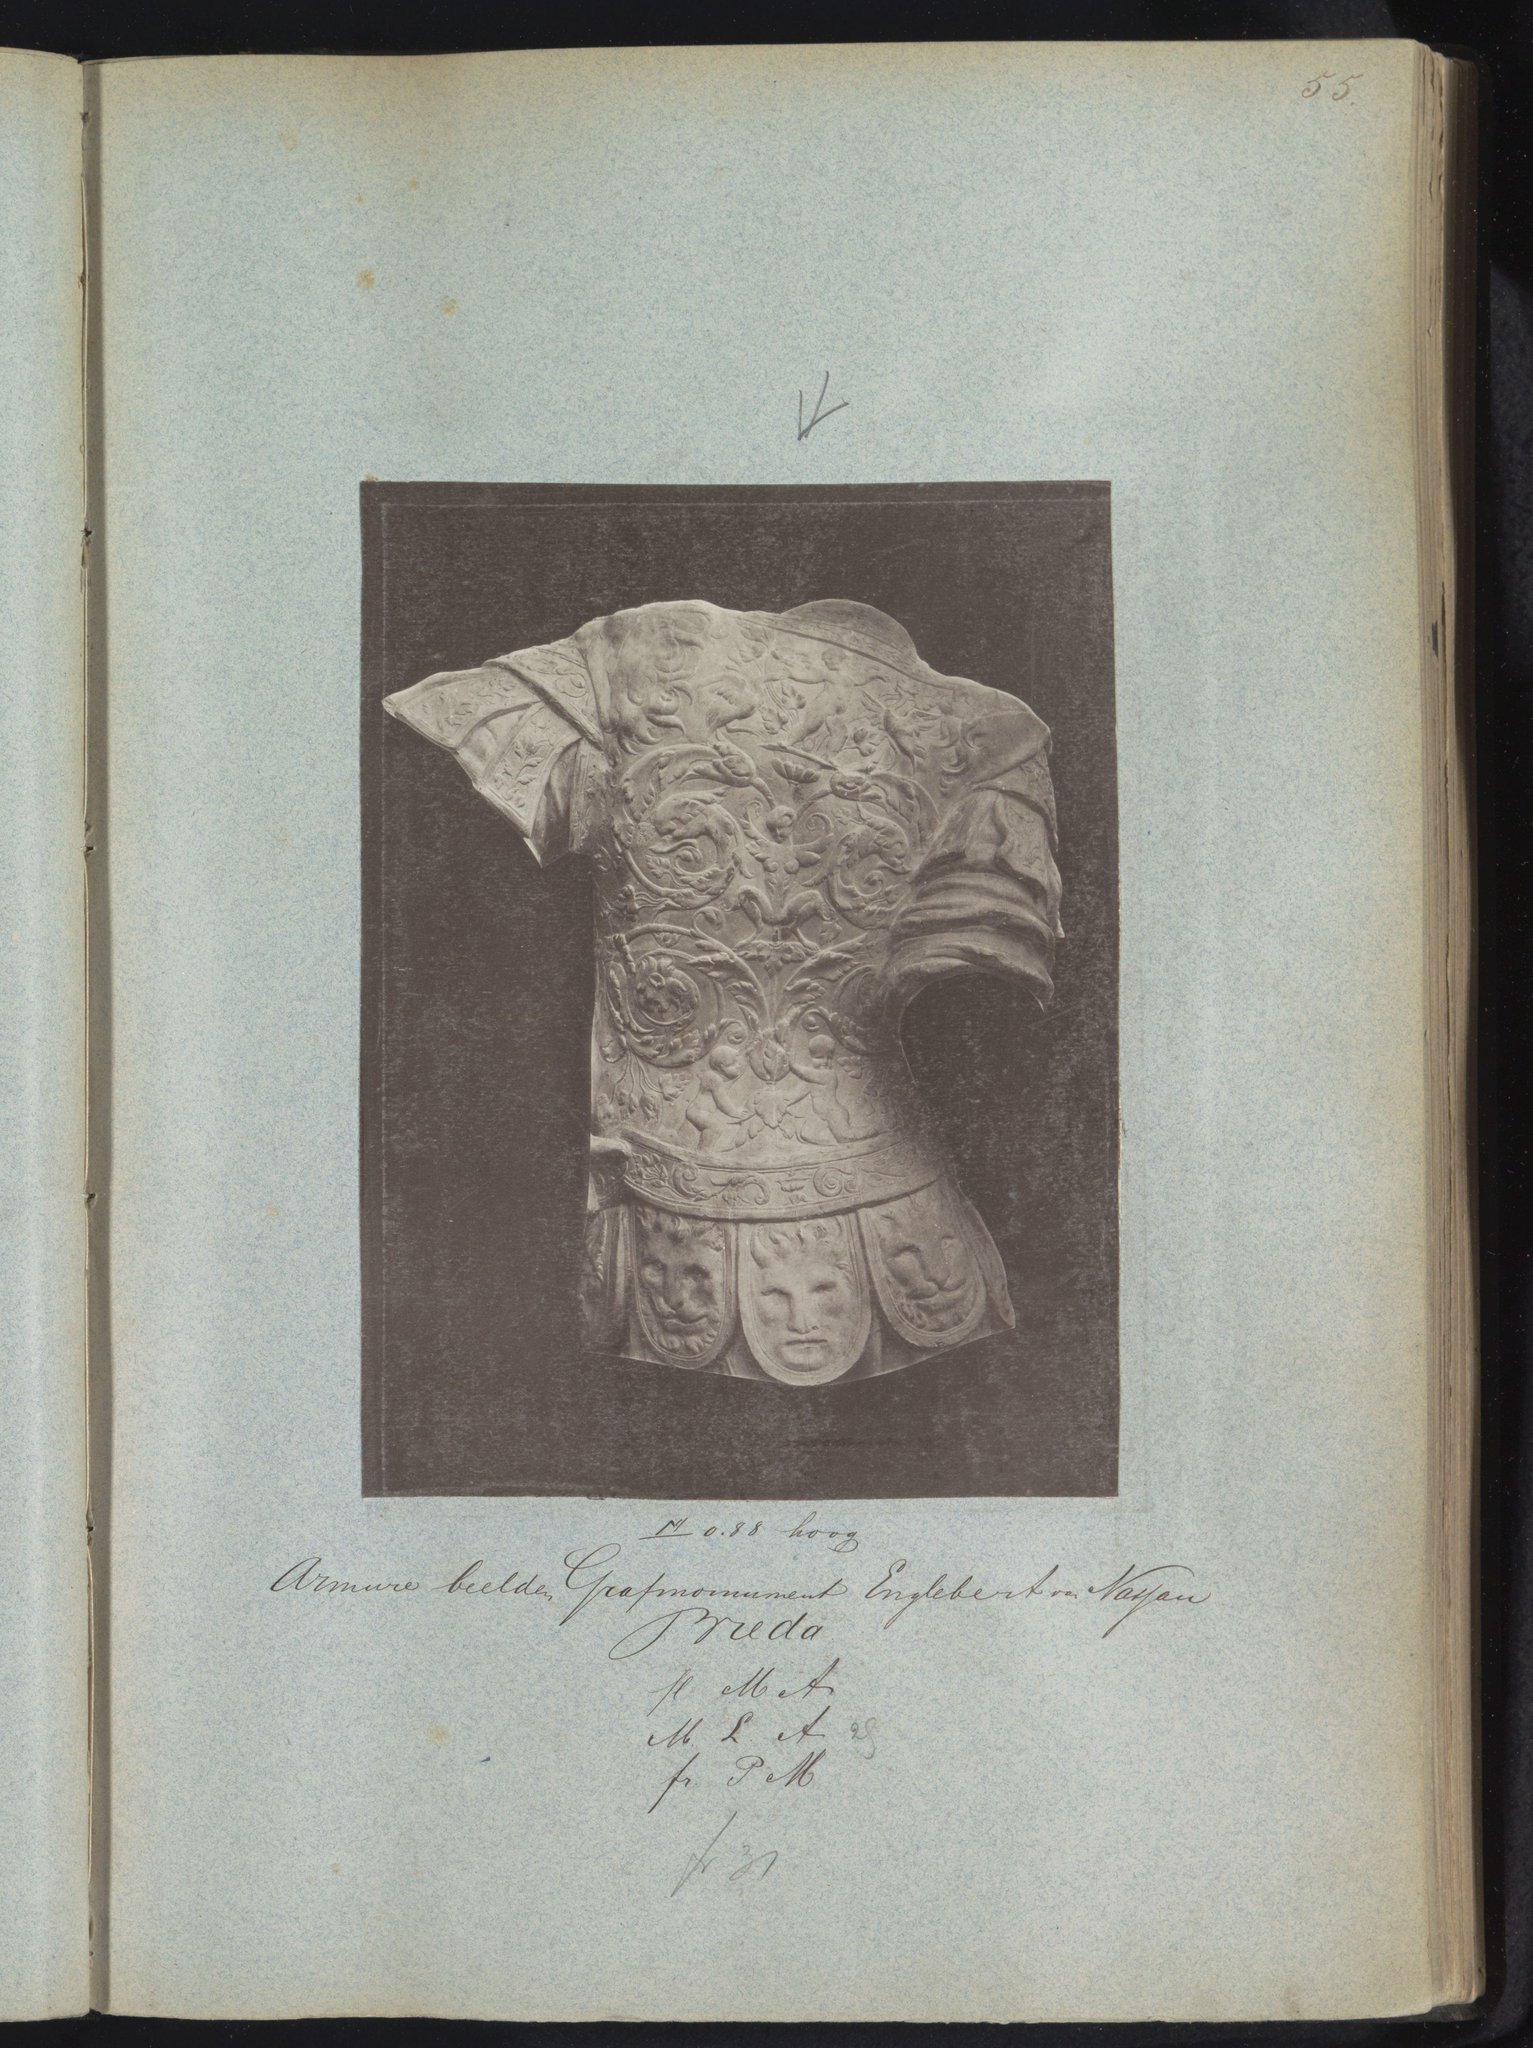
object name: photograph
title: Gipsen afgietsel van een harnas van het grafmonument van Engelbrecht II, graaf van Nassau, uit de Prinsenkapel van de Onze-Lieve-Vrouwekerk te Breda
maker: Anonymous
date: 1875-1900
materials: paper, photographic support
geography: breda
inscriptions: annotation: ‘M 0.88 hoog’, annotation, annotation: ‘Armure beelden Graftombe Englebert van Nassau / Breda’